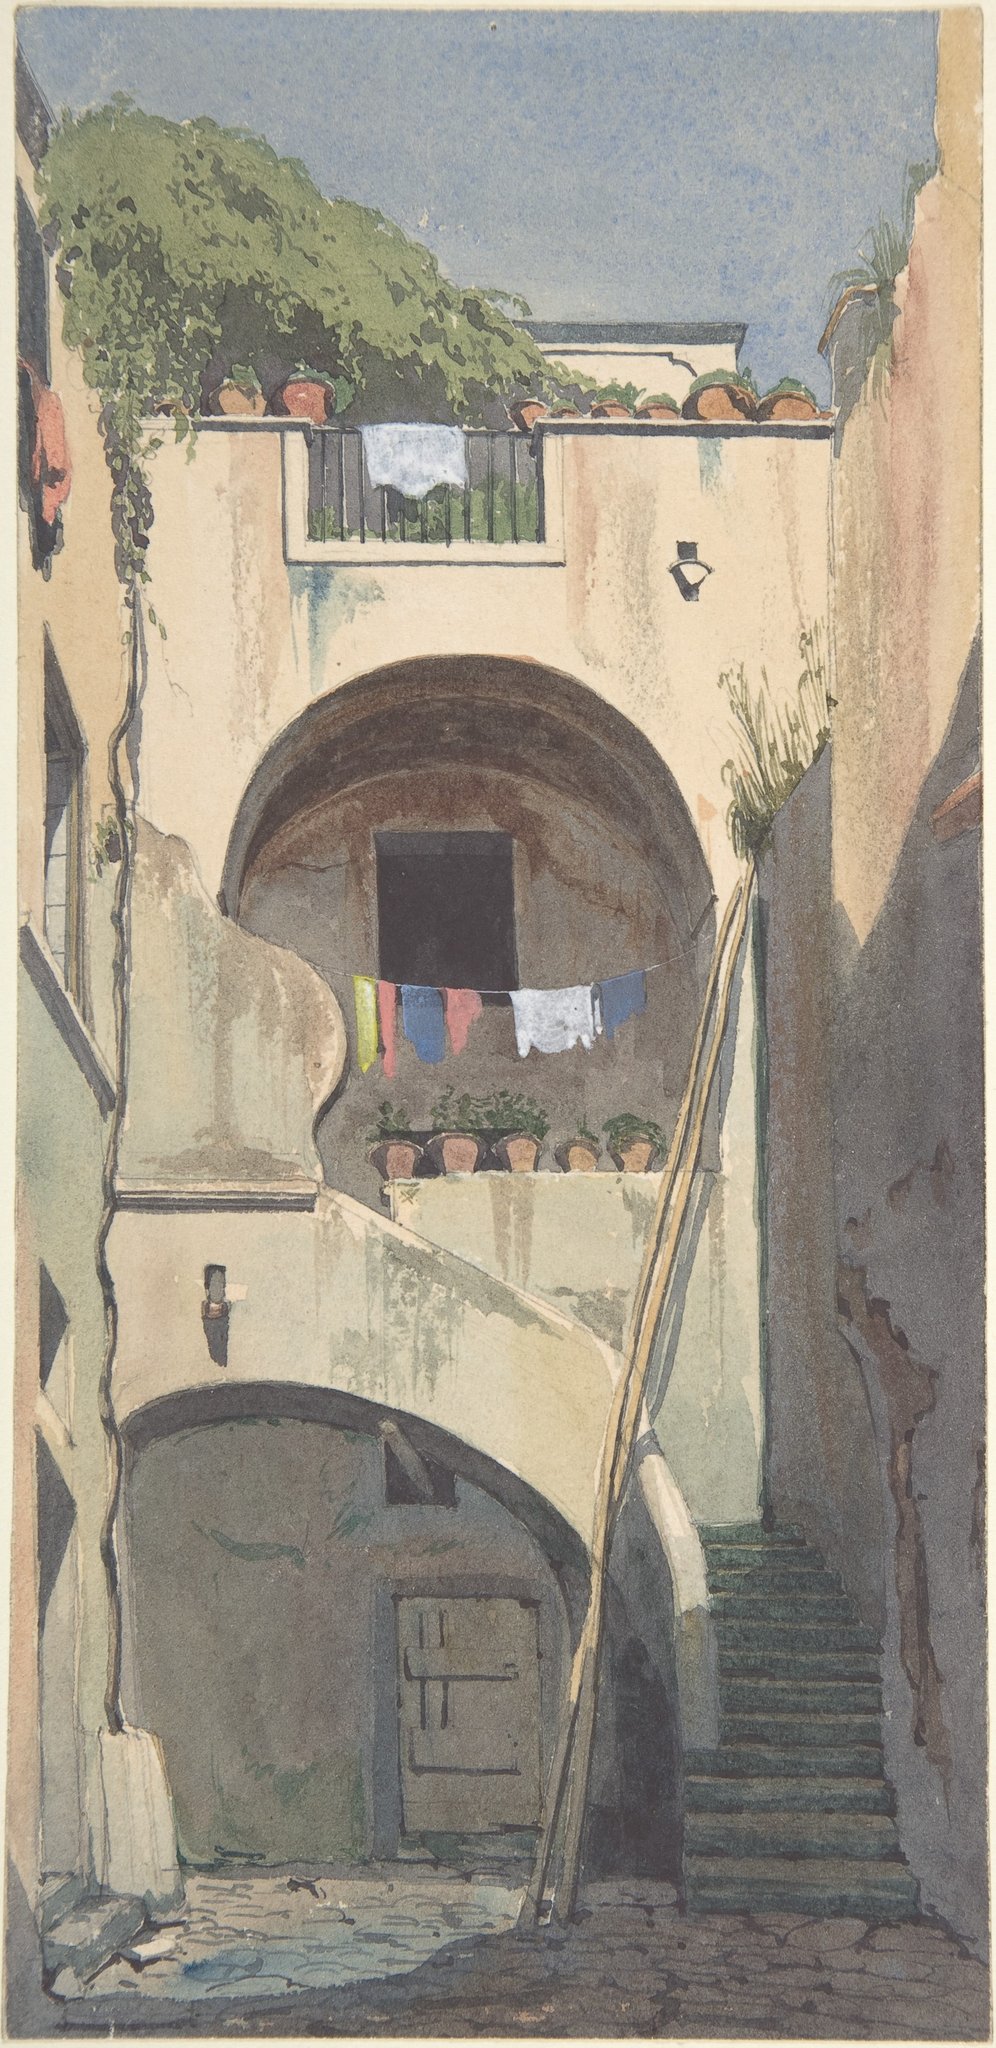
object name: drawing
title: A House at Sorrento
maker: thomas hartley cromek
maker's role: artist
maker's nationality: british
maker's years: 1809-1873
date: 1834-1866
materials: gouache, graphite, watercolor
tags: houses,stairs